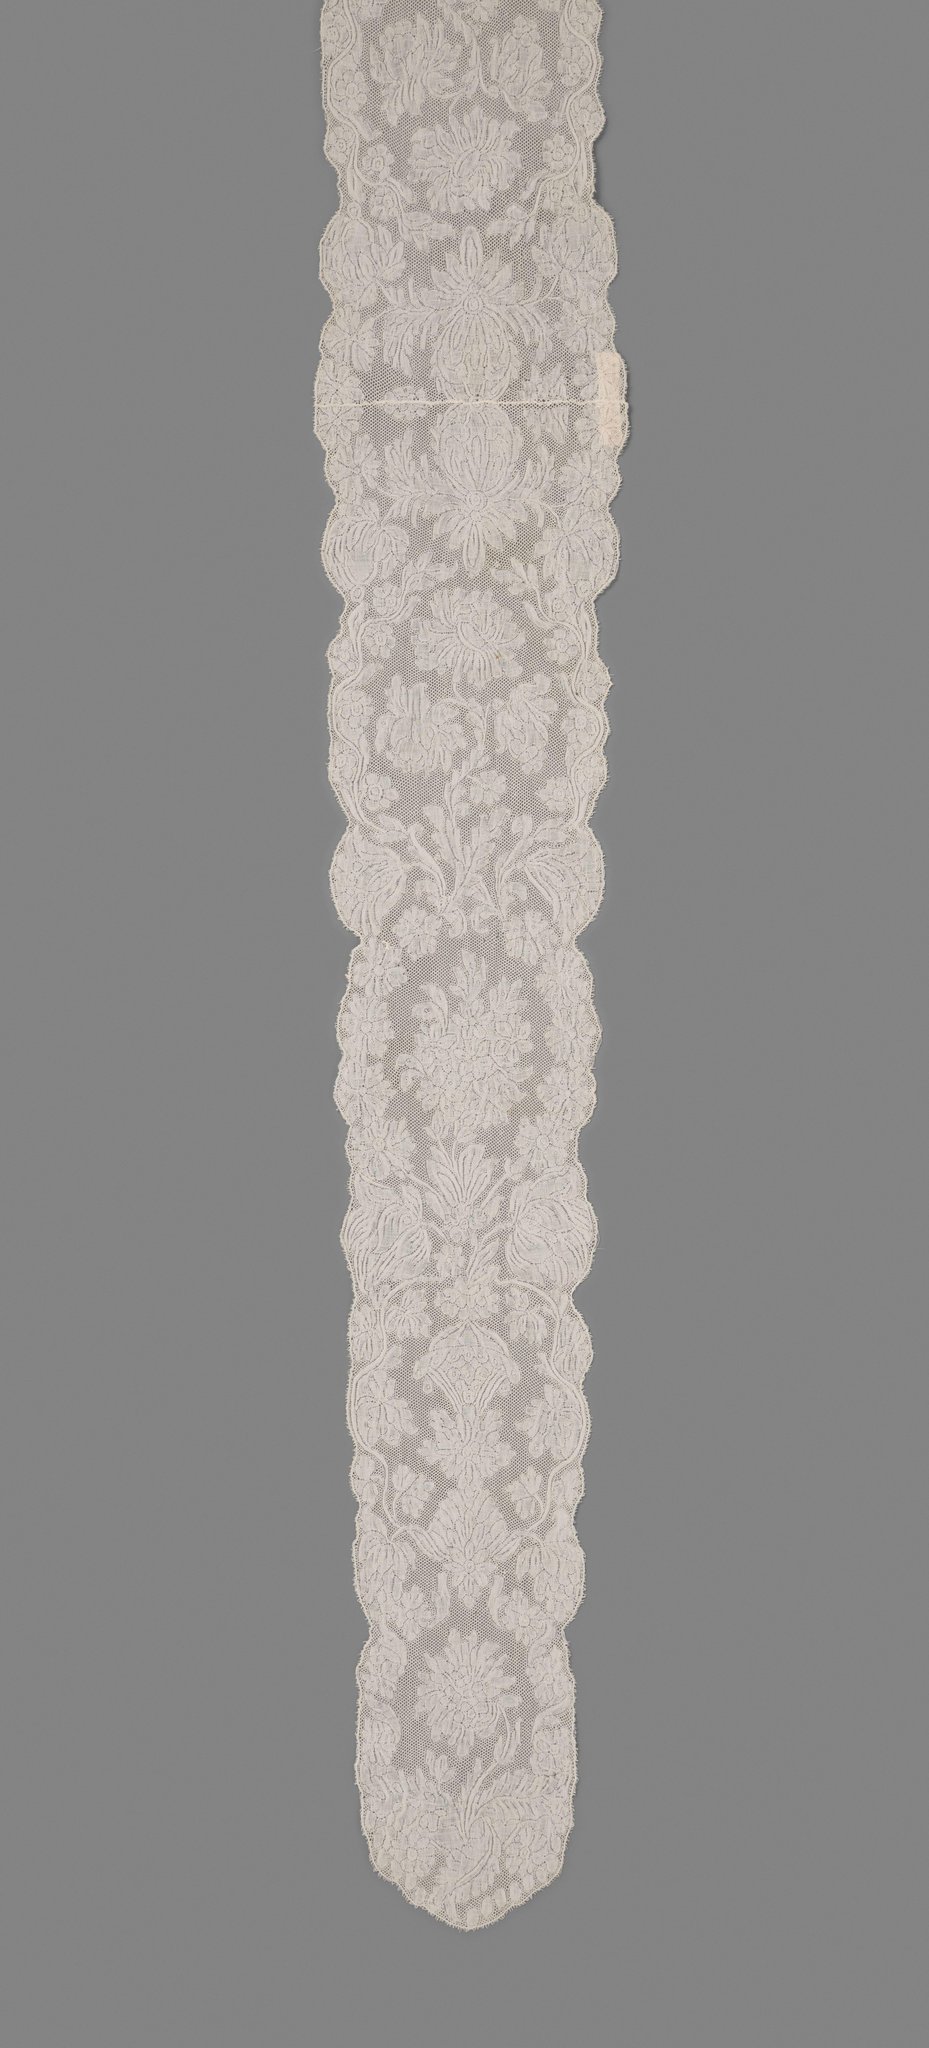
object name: lappet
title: Mutsenslip (barbe) van Valenciennes-kant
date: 1750-1760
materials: linen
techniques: lace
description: Mutsenslip die bestaat uit twee aan elkaar genaaide mutsenslippen van kloskant. Het patroon heeft bloemen en bladeren. De geschulpte rand is afgezet met picots.